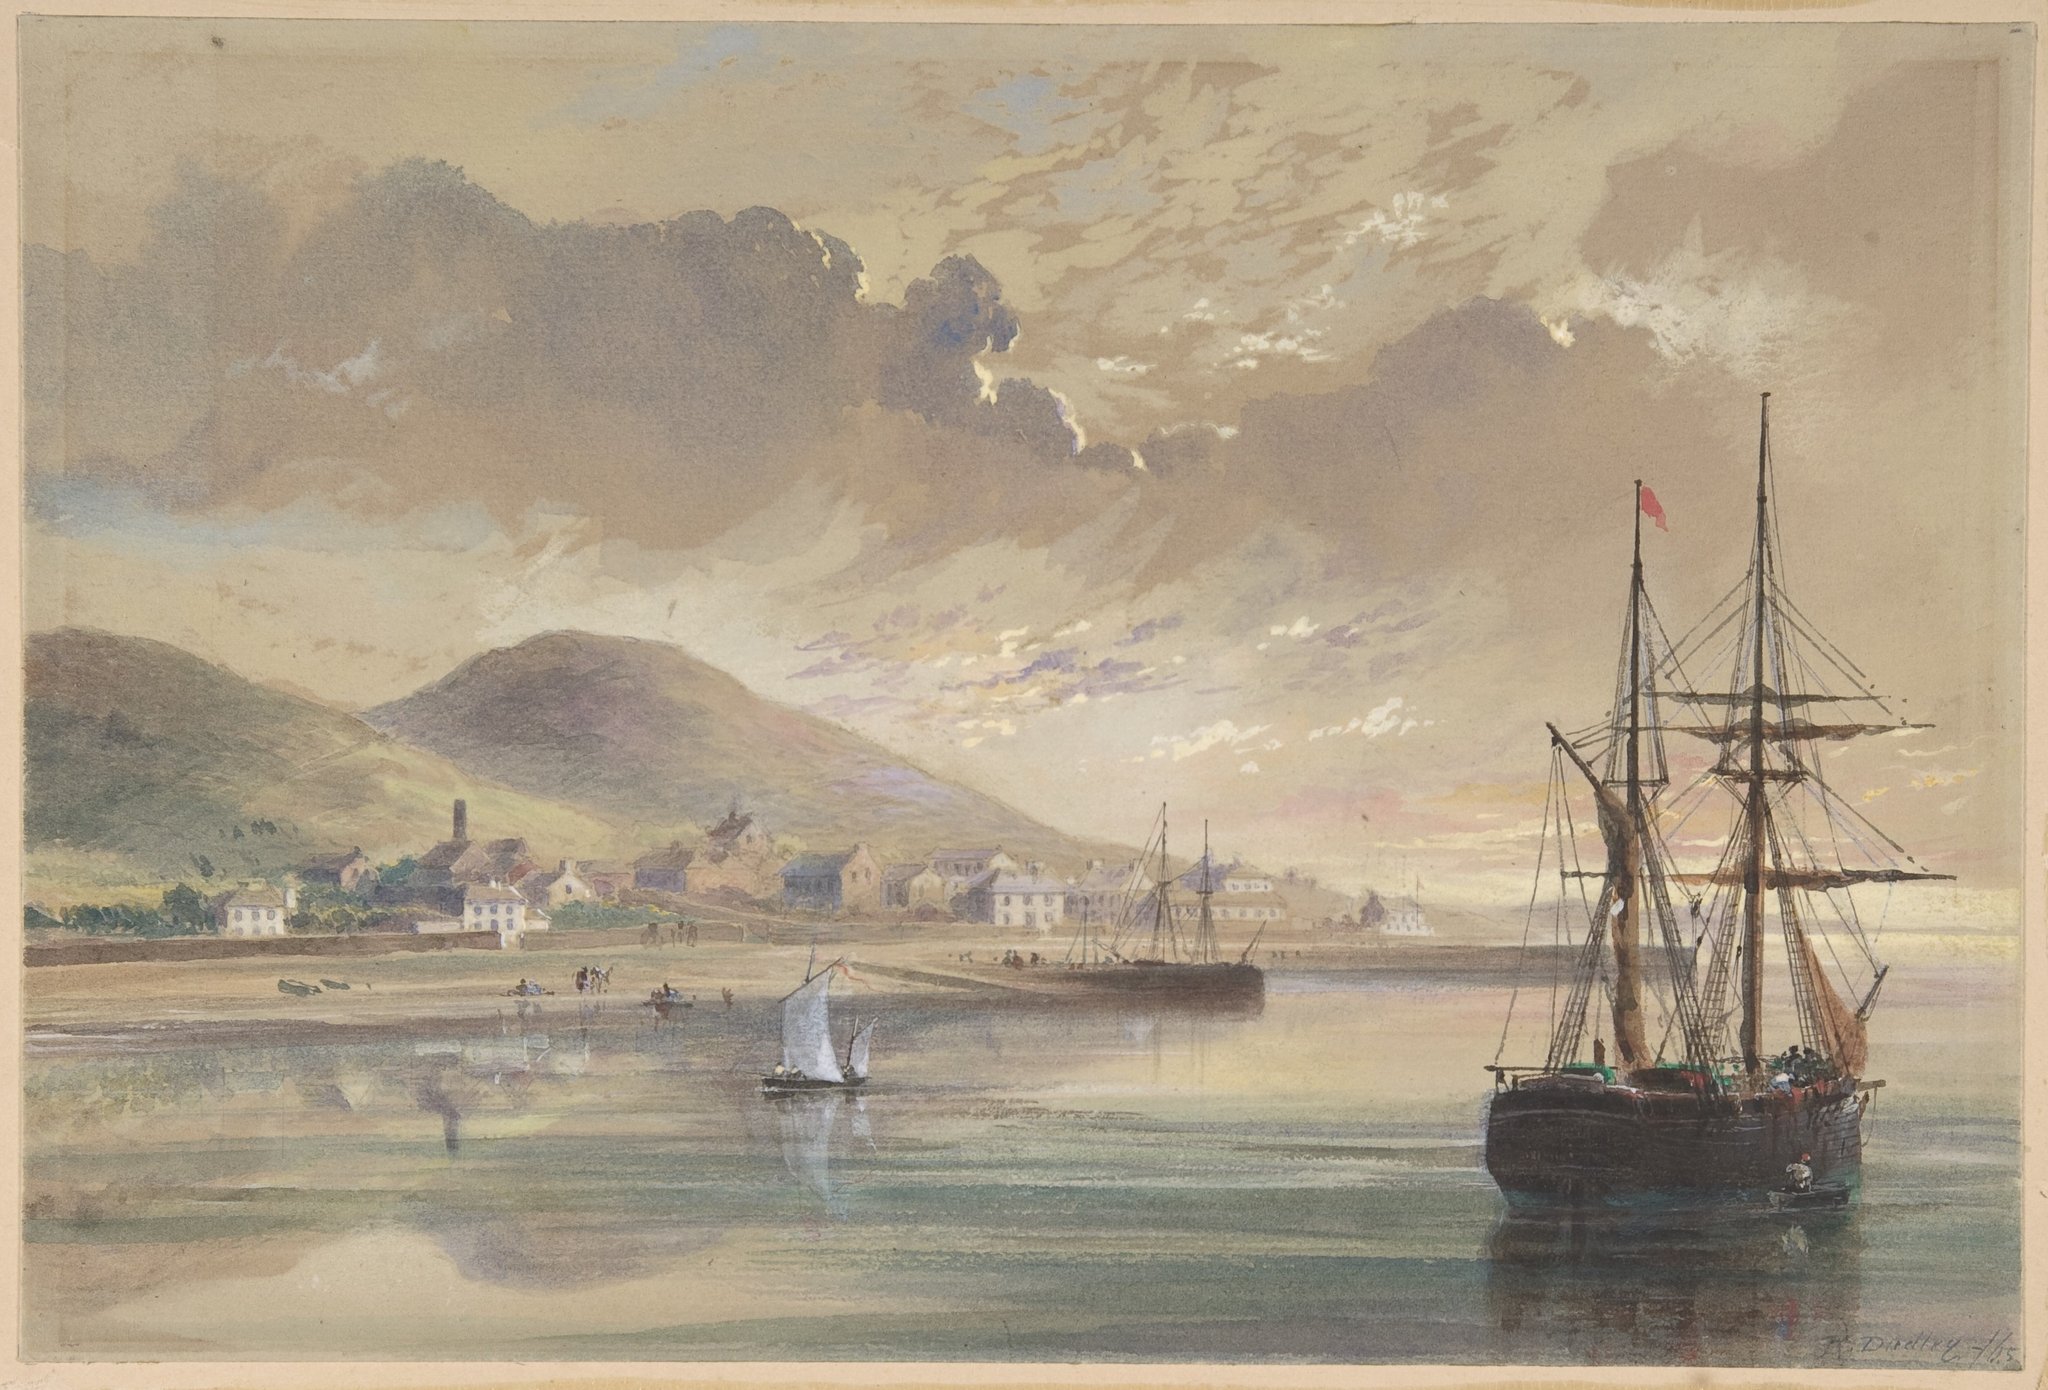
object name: drawing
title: Valentia in 1857-1858 at the Time of the Laying of the Former Cable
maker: robert charles dudley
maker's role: artist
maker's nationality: british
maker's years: 1826-1909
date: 1865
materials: gouache, graphite, watercolor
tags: landscapes,boats,transatlantic cable